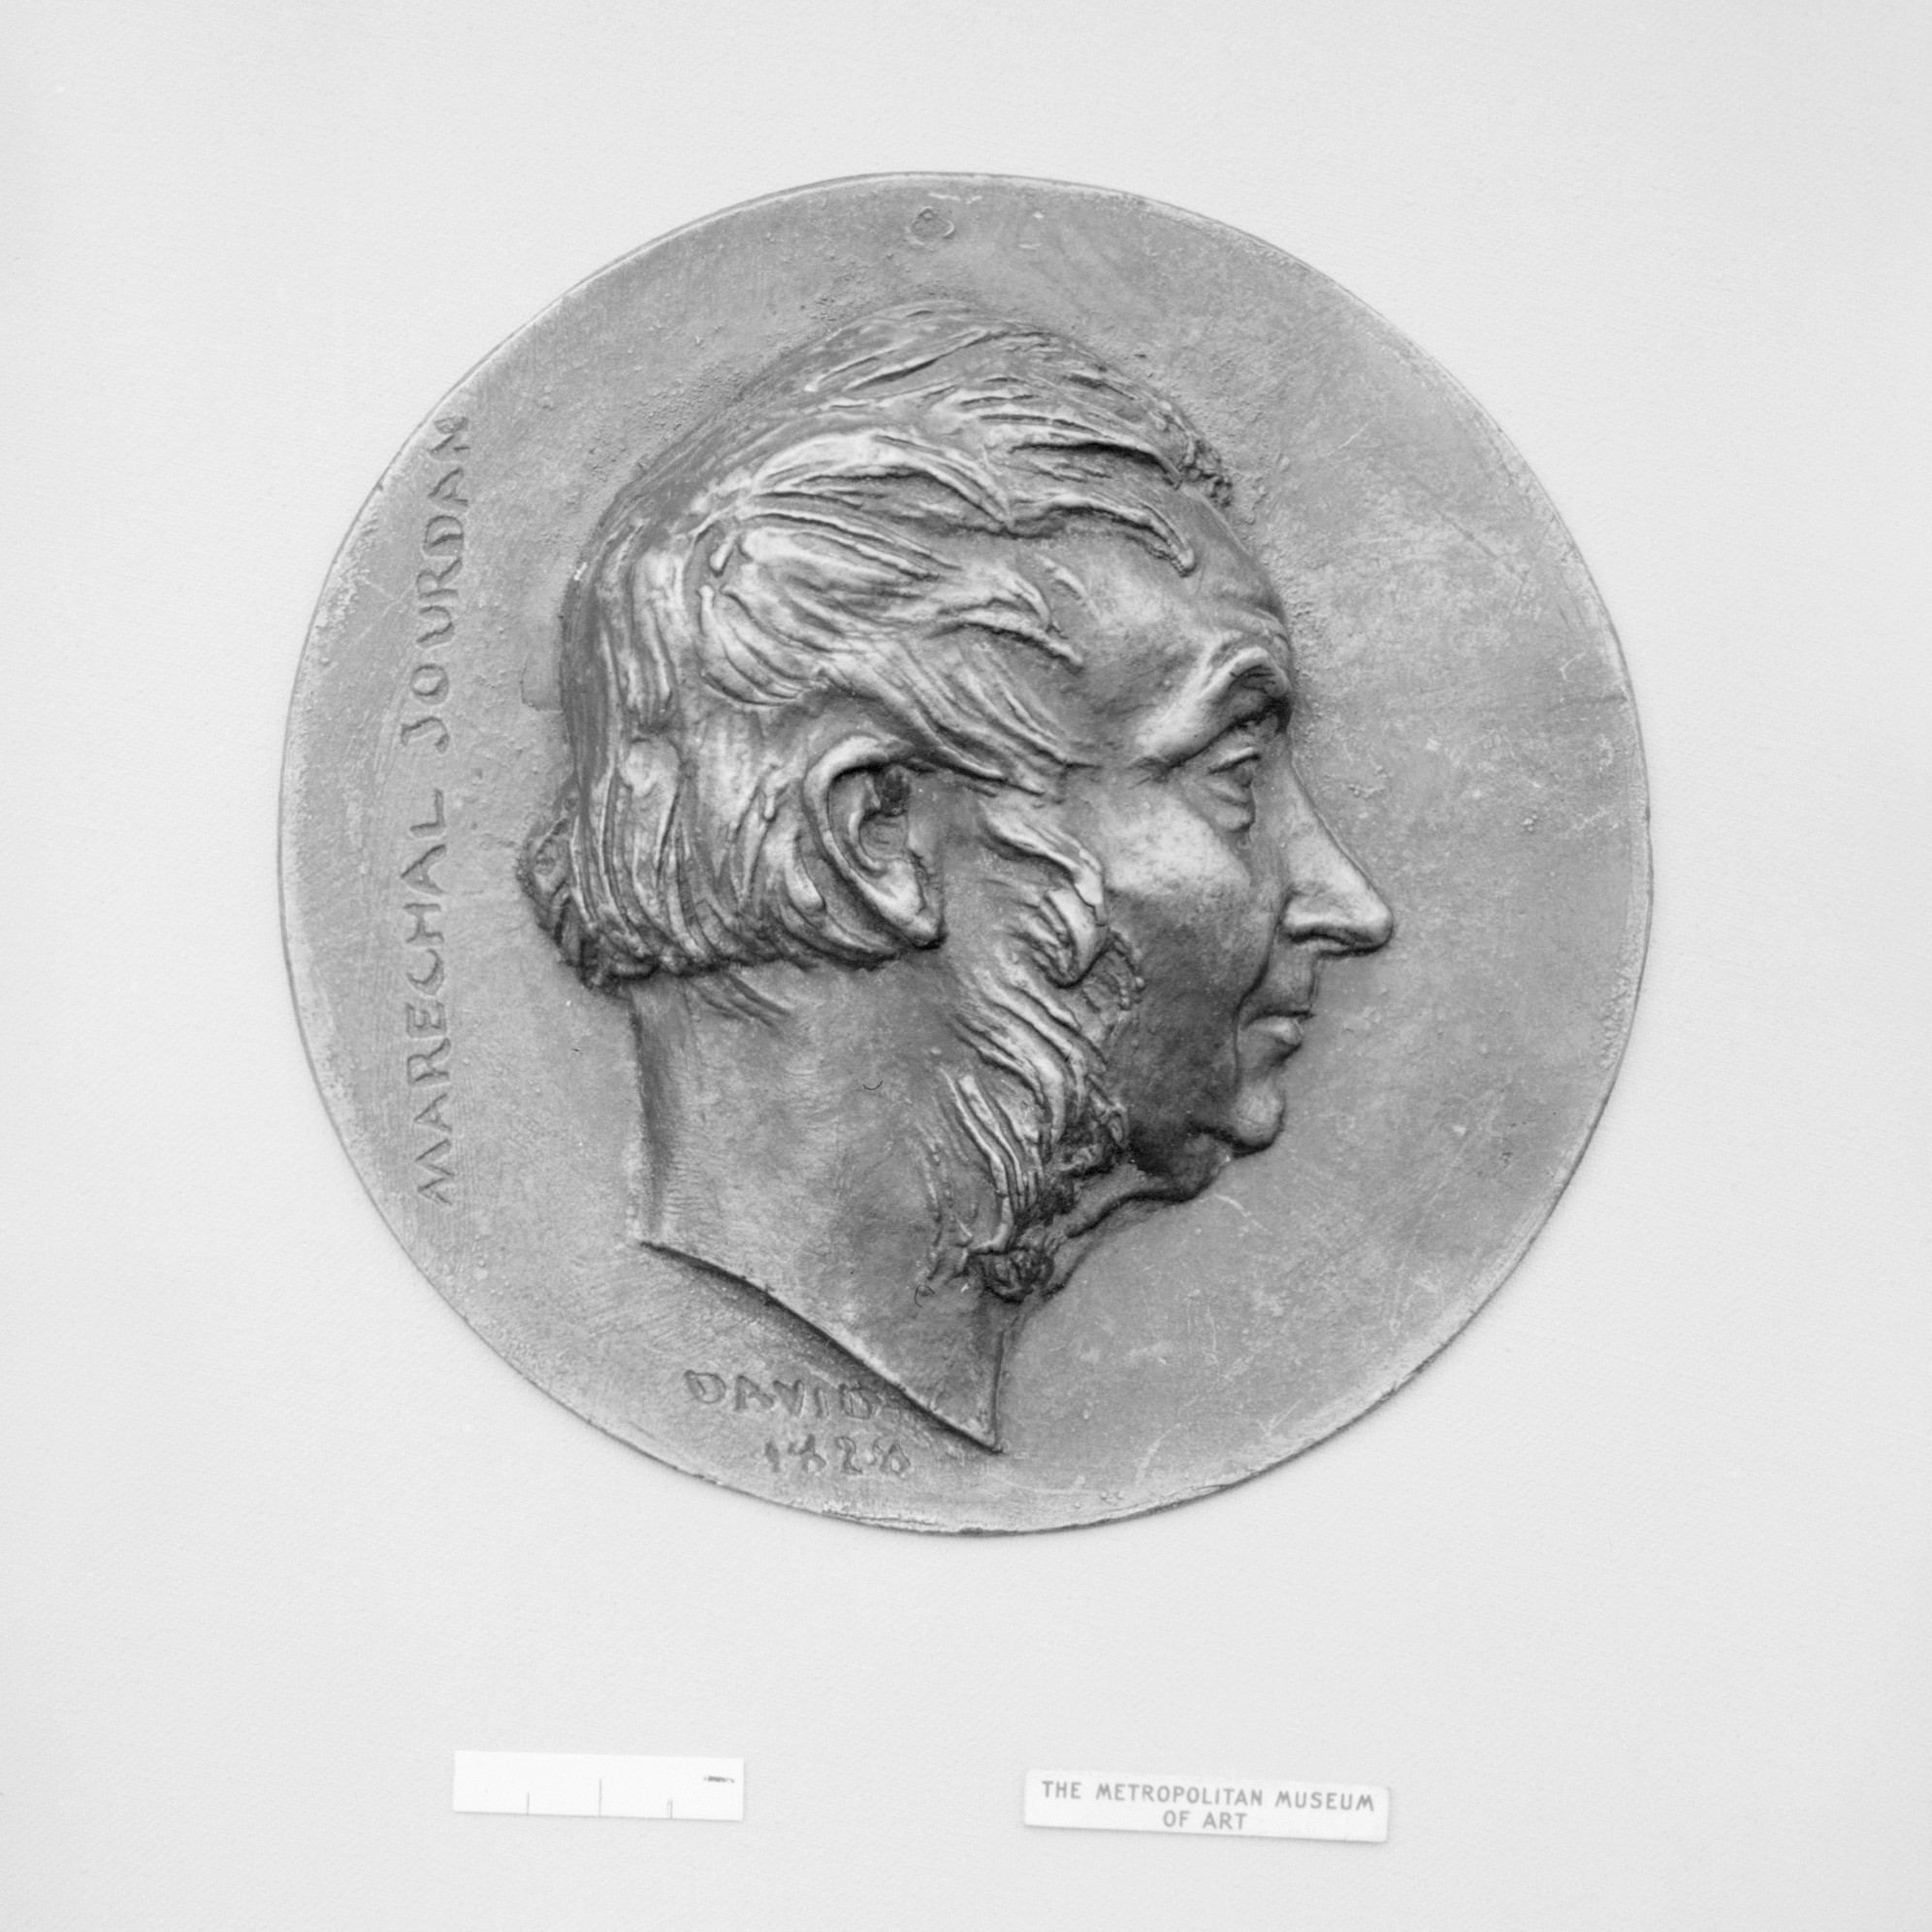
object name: medallion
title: Jean-Baptiste Jourdan (1762–1833), Marshal of France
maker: pierre jean david d'angers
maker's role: artist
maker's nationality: french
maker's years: 1788-1856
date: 1828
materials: bronze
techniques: casting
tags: men,profiles